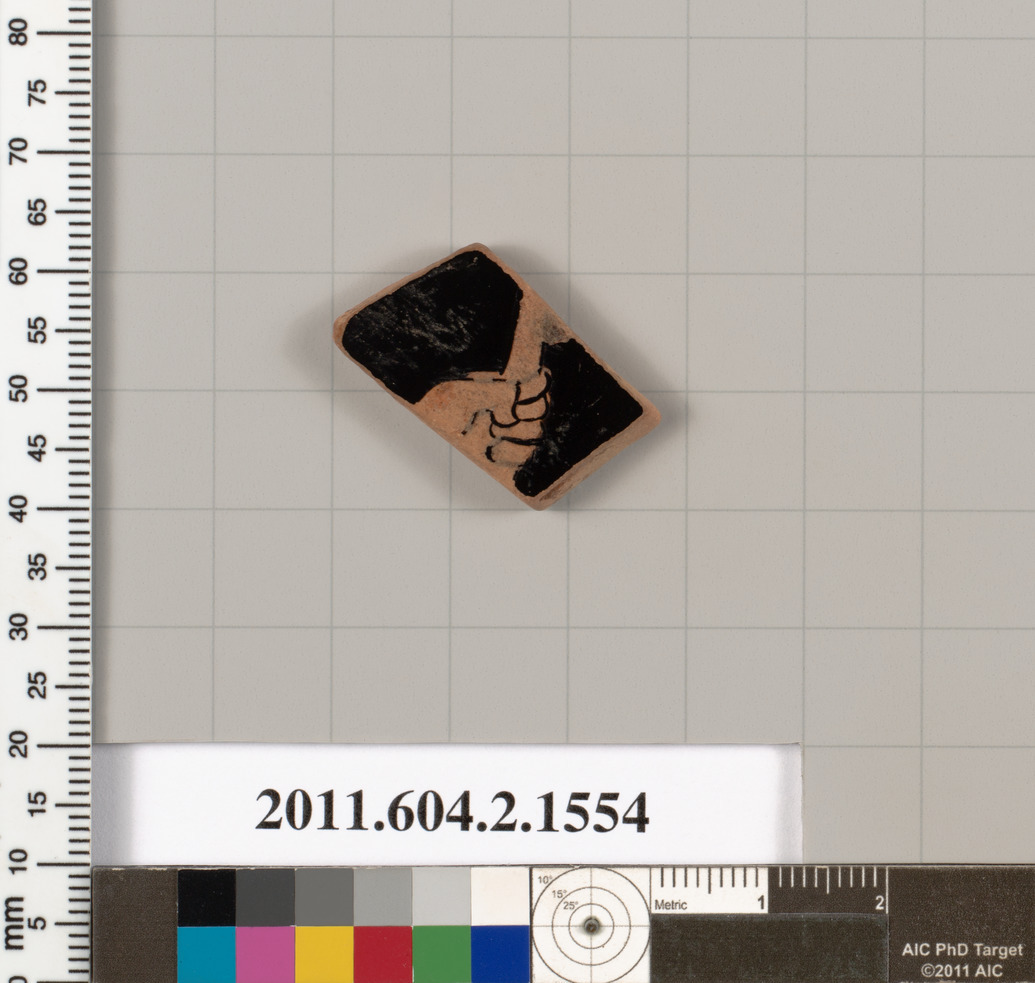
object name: skyphos fragment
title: Terracotta fragment of a skyphos (deep drinking cup)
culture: greek, attic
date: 475-451 BCE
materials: terracotta